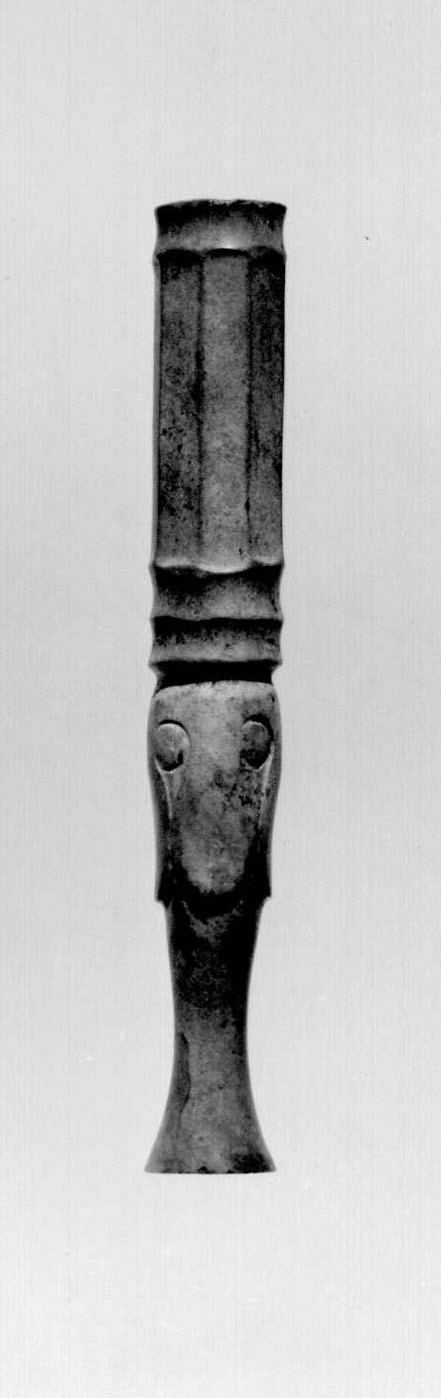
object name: furniture post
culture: chinese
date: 206 BCE-220 CE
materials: jade